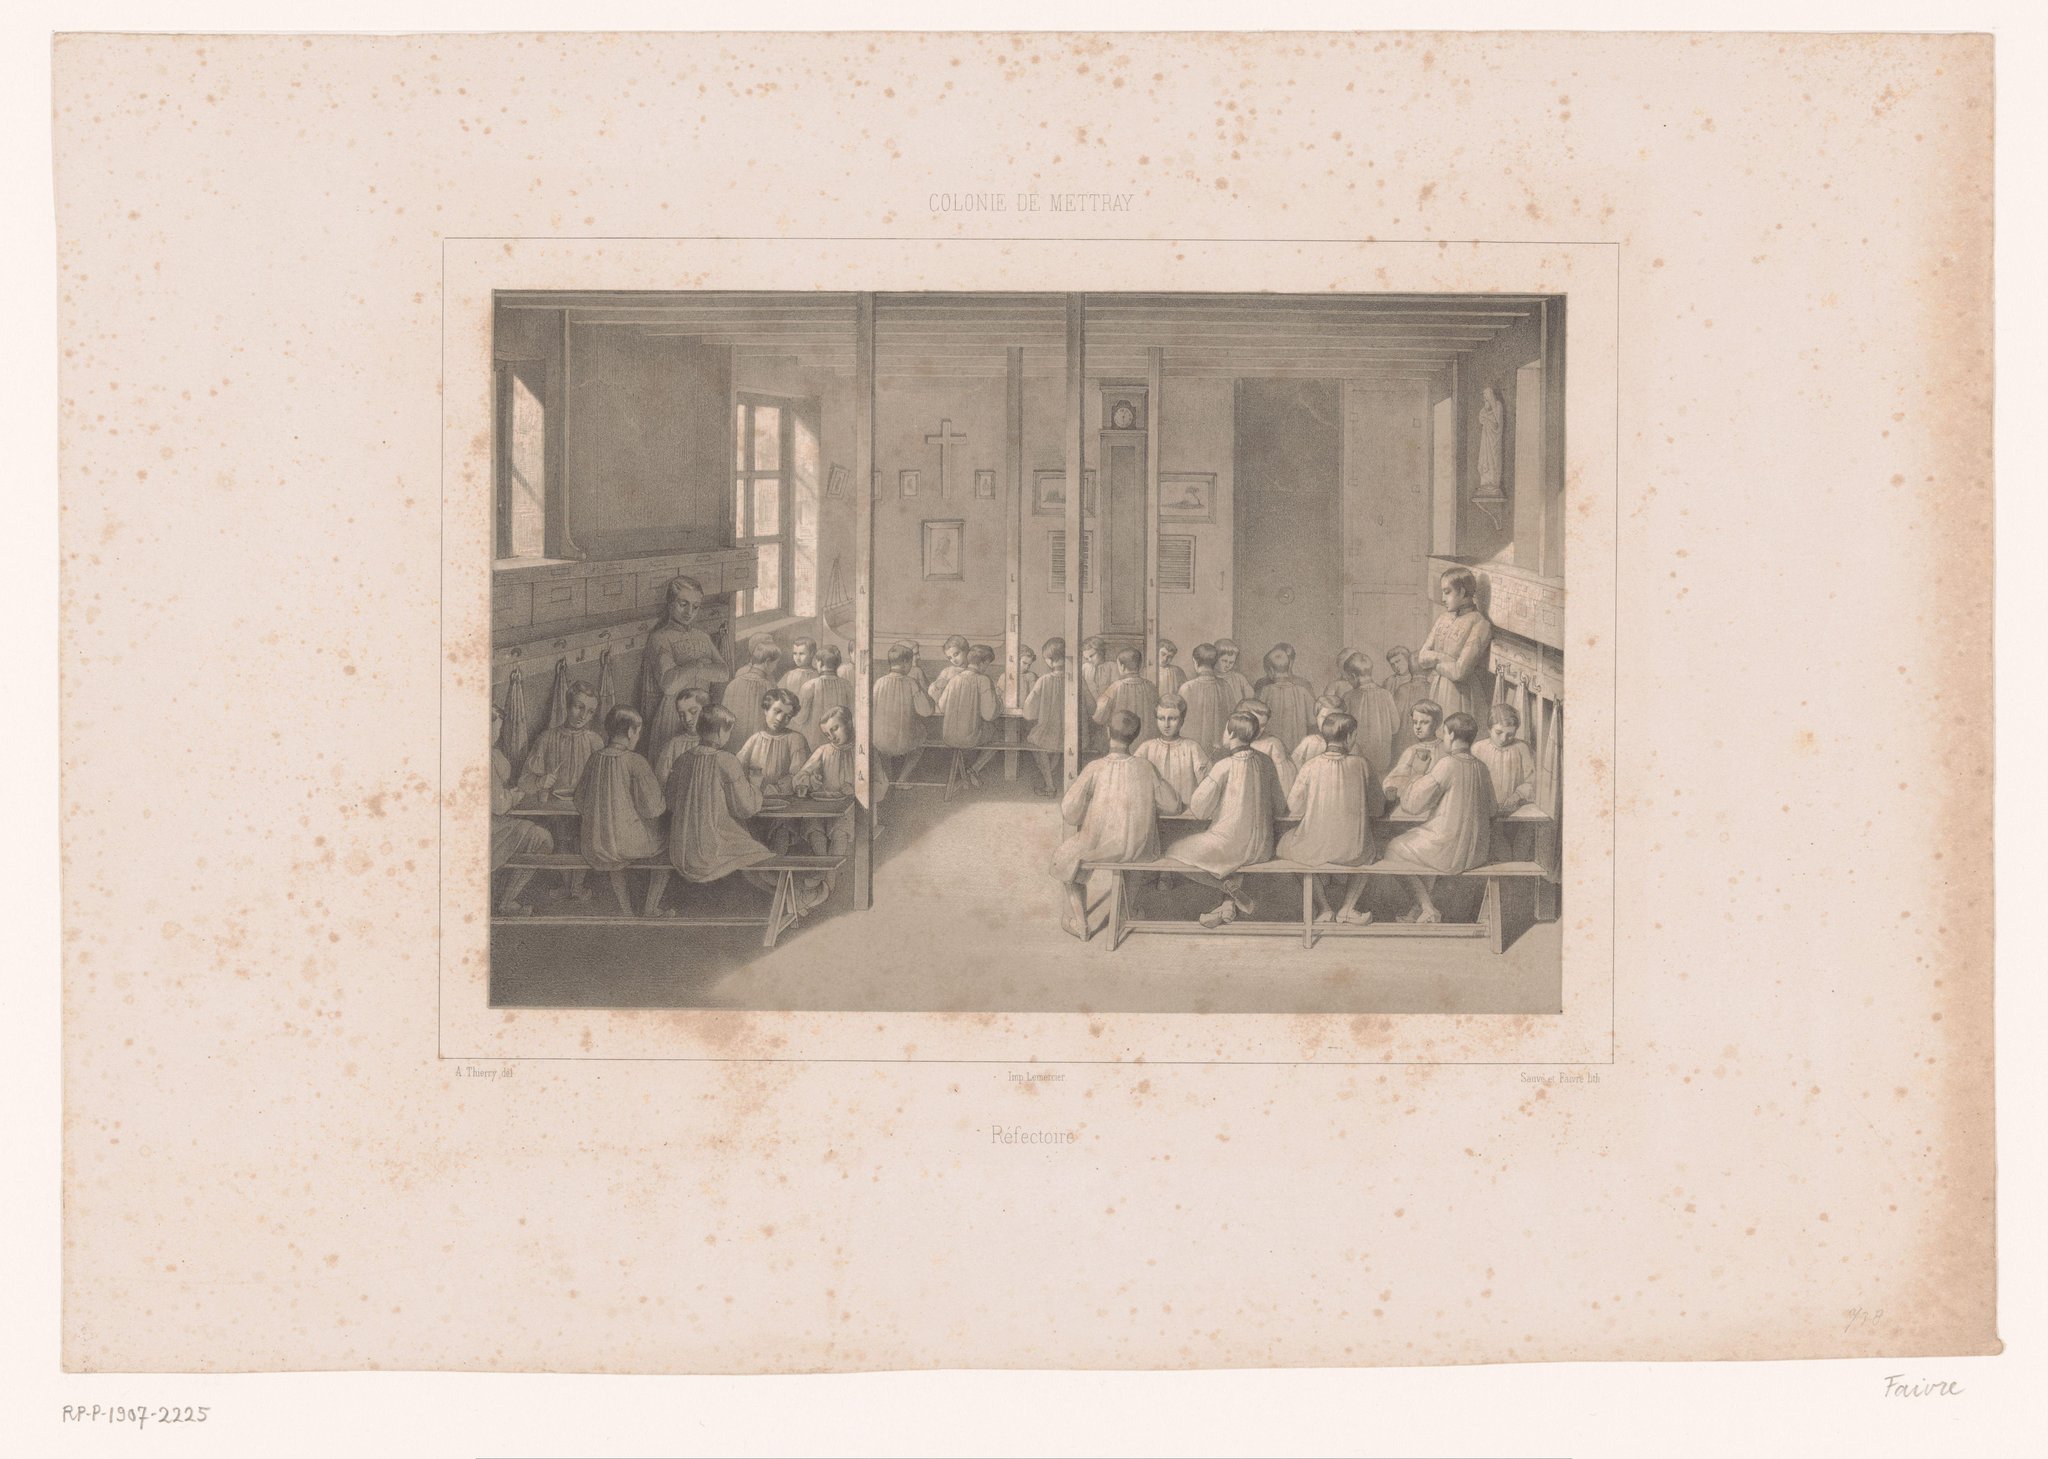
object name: print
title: Voorstellingen van de strafkolonie in Mettray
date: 1844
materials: paper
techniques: tone lithography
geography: paris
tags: refectory ~ monastery, workhouse, penal camp, penitentiary, chain gang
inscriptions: collector's mark: Lugt 2228a